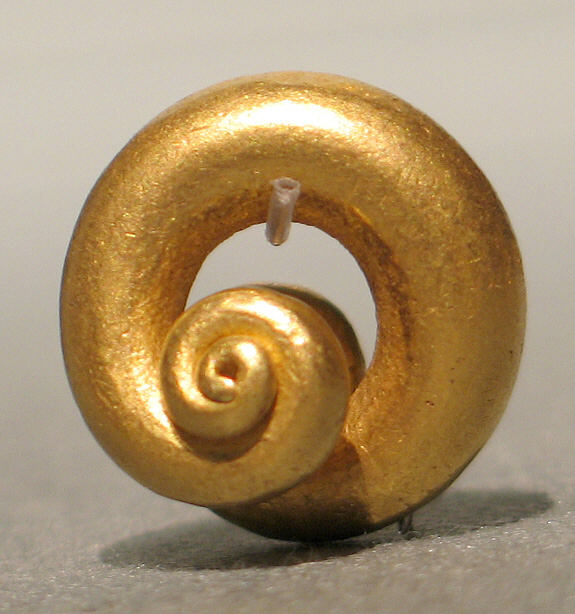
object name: earring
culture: indonesian, javanese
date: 701-833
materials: gold